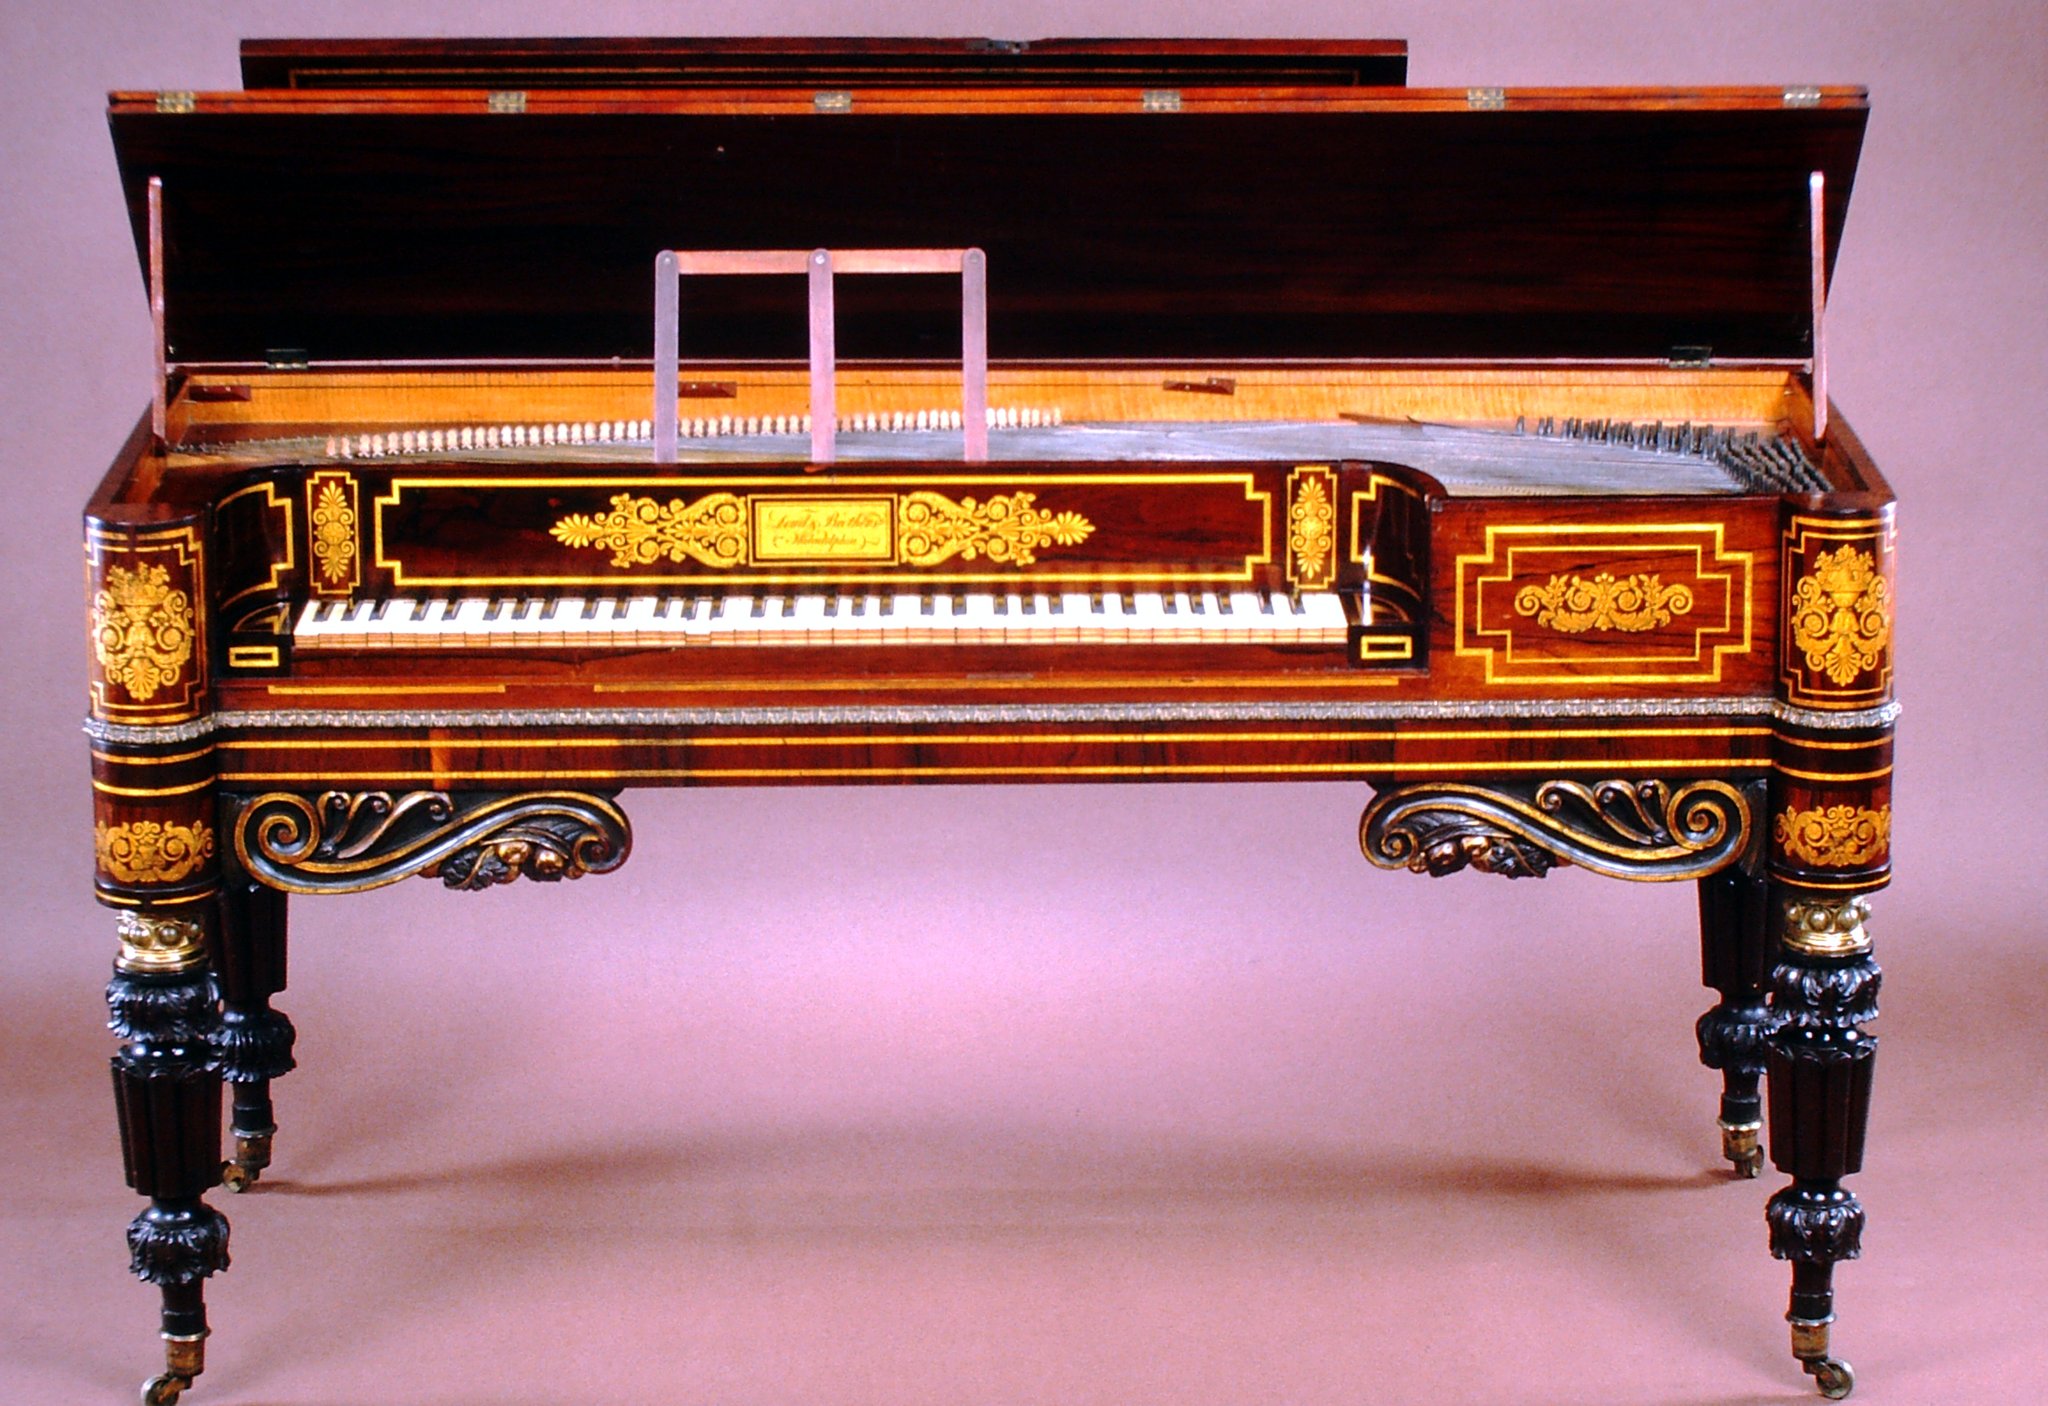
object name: square piano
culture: american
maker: loud & brothers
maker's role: manufacturer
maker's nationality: american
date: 1825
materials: gilt, wood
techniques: veneering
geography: united states